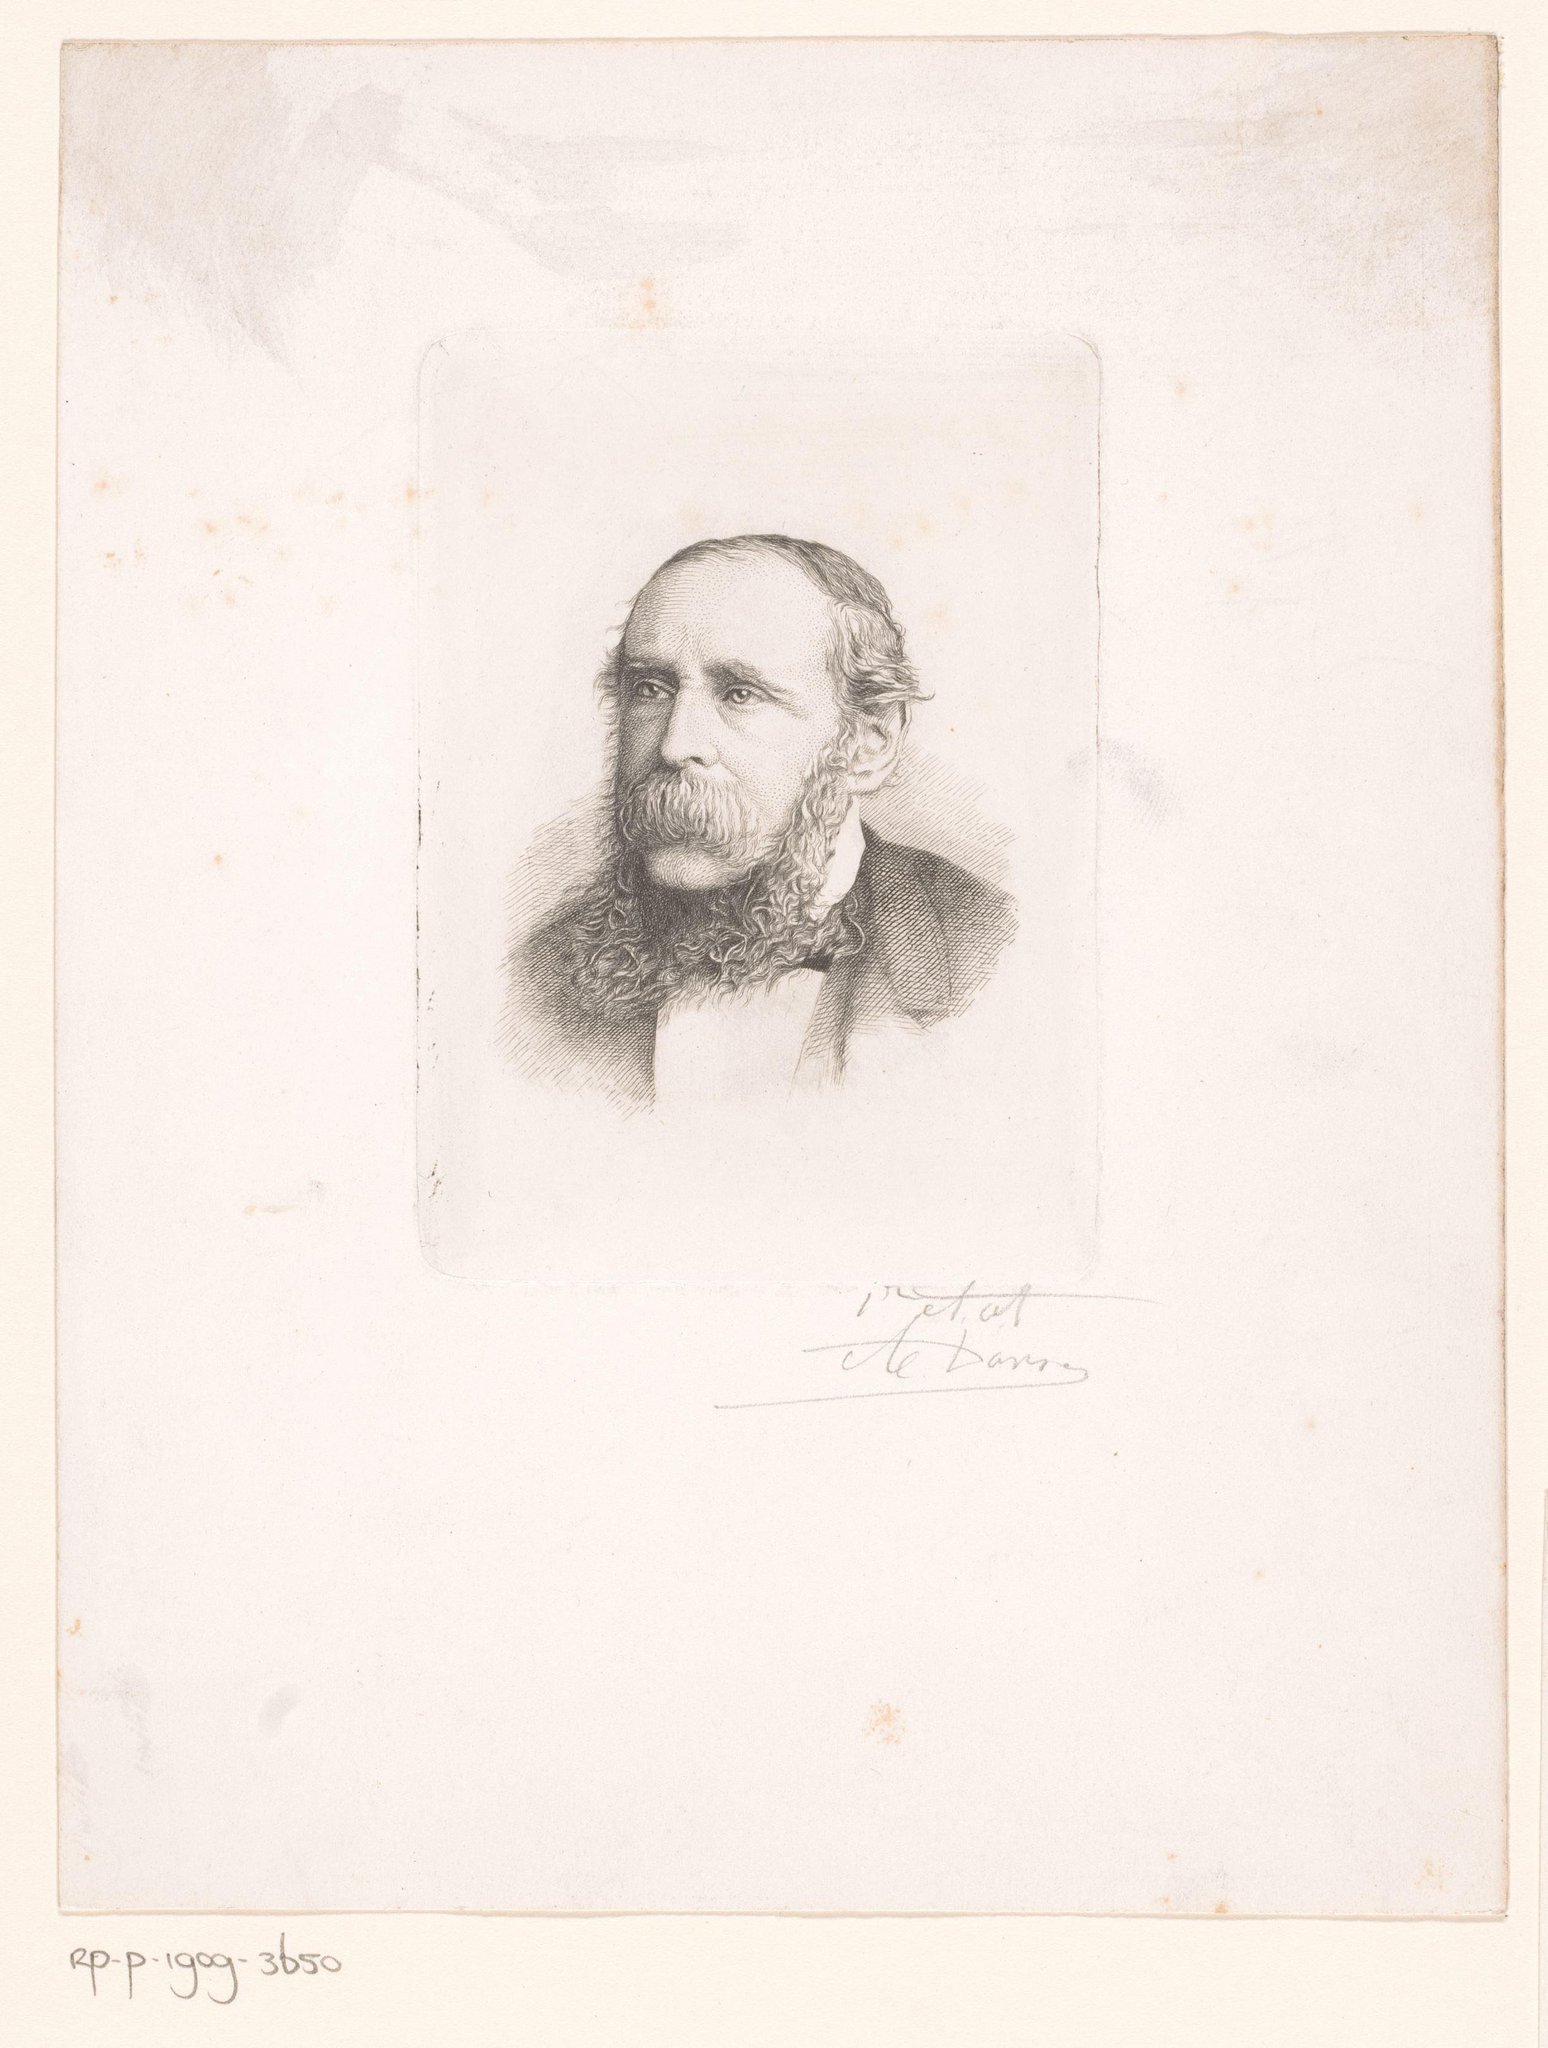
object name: print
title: Portret van Jean Servais Stas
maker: auguste danse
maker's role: print maker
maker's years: 1829-1929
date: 1839-1909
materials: paper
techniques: etching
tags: brussels, historical person (...) - historical person (...) portrayed alone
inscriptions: annotation: ‘1er état’, collector's mark: Lugt 2228